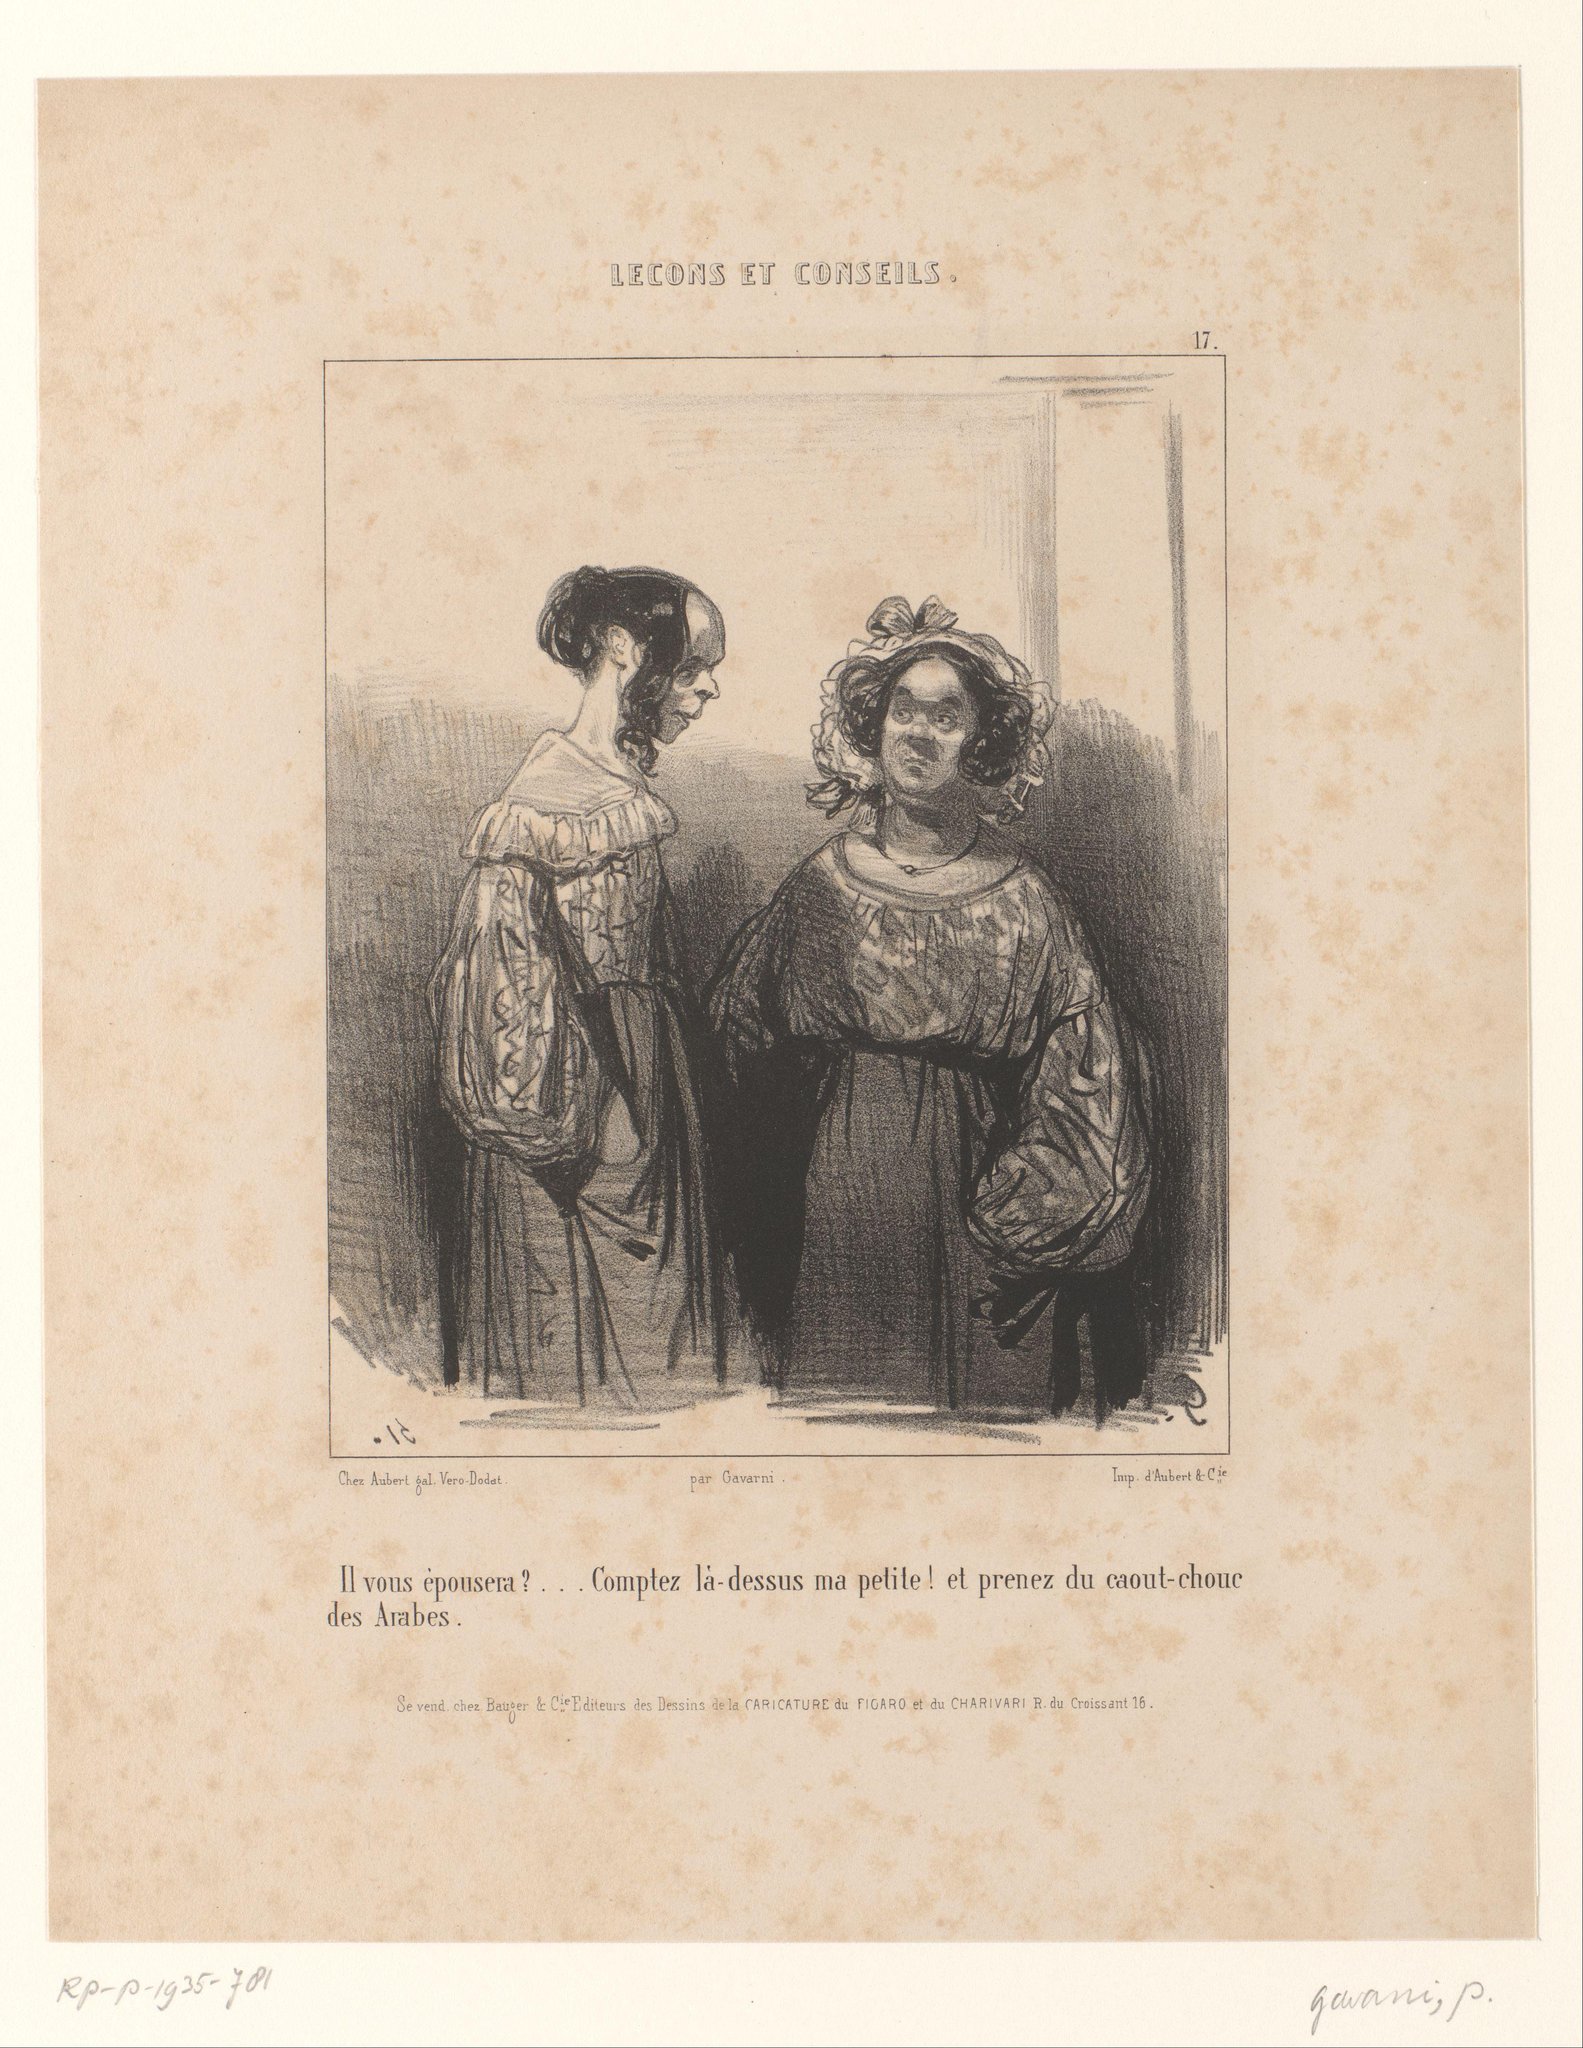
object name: cartoon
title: Leçons et conseils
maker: paul gavarni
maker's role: draughtsman, print maker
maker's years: 1804-1866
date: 1840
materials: paper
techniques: lithograph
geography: paris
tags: counsel; 'consiglio' (ripa), old woman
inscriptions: collector's mark: Lugt 2228a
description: Prent gebruikt voor: Le Charivari, 13 december 1840.